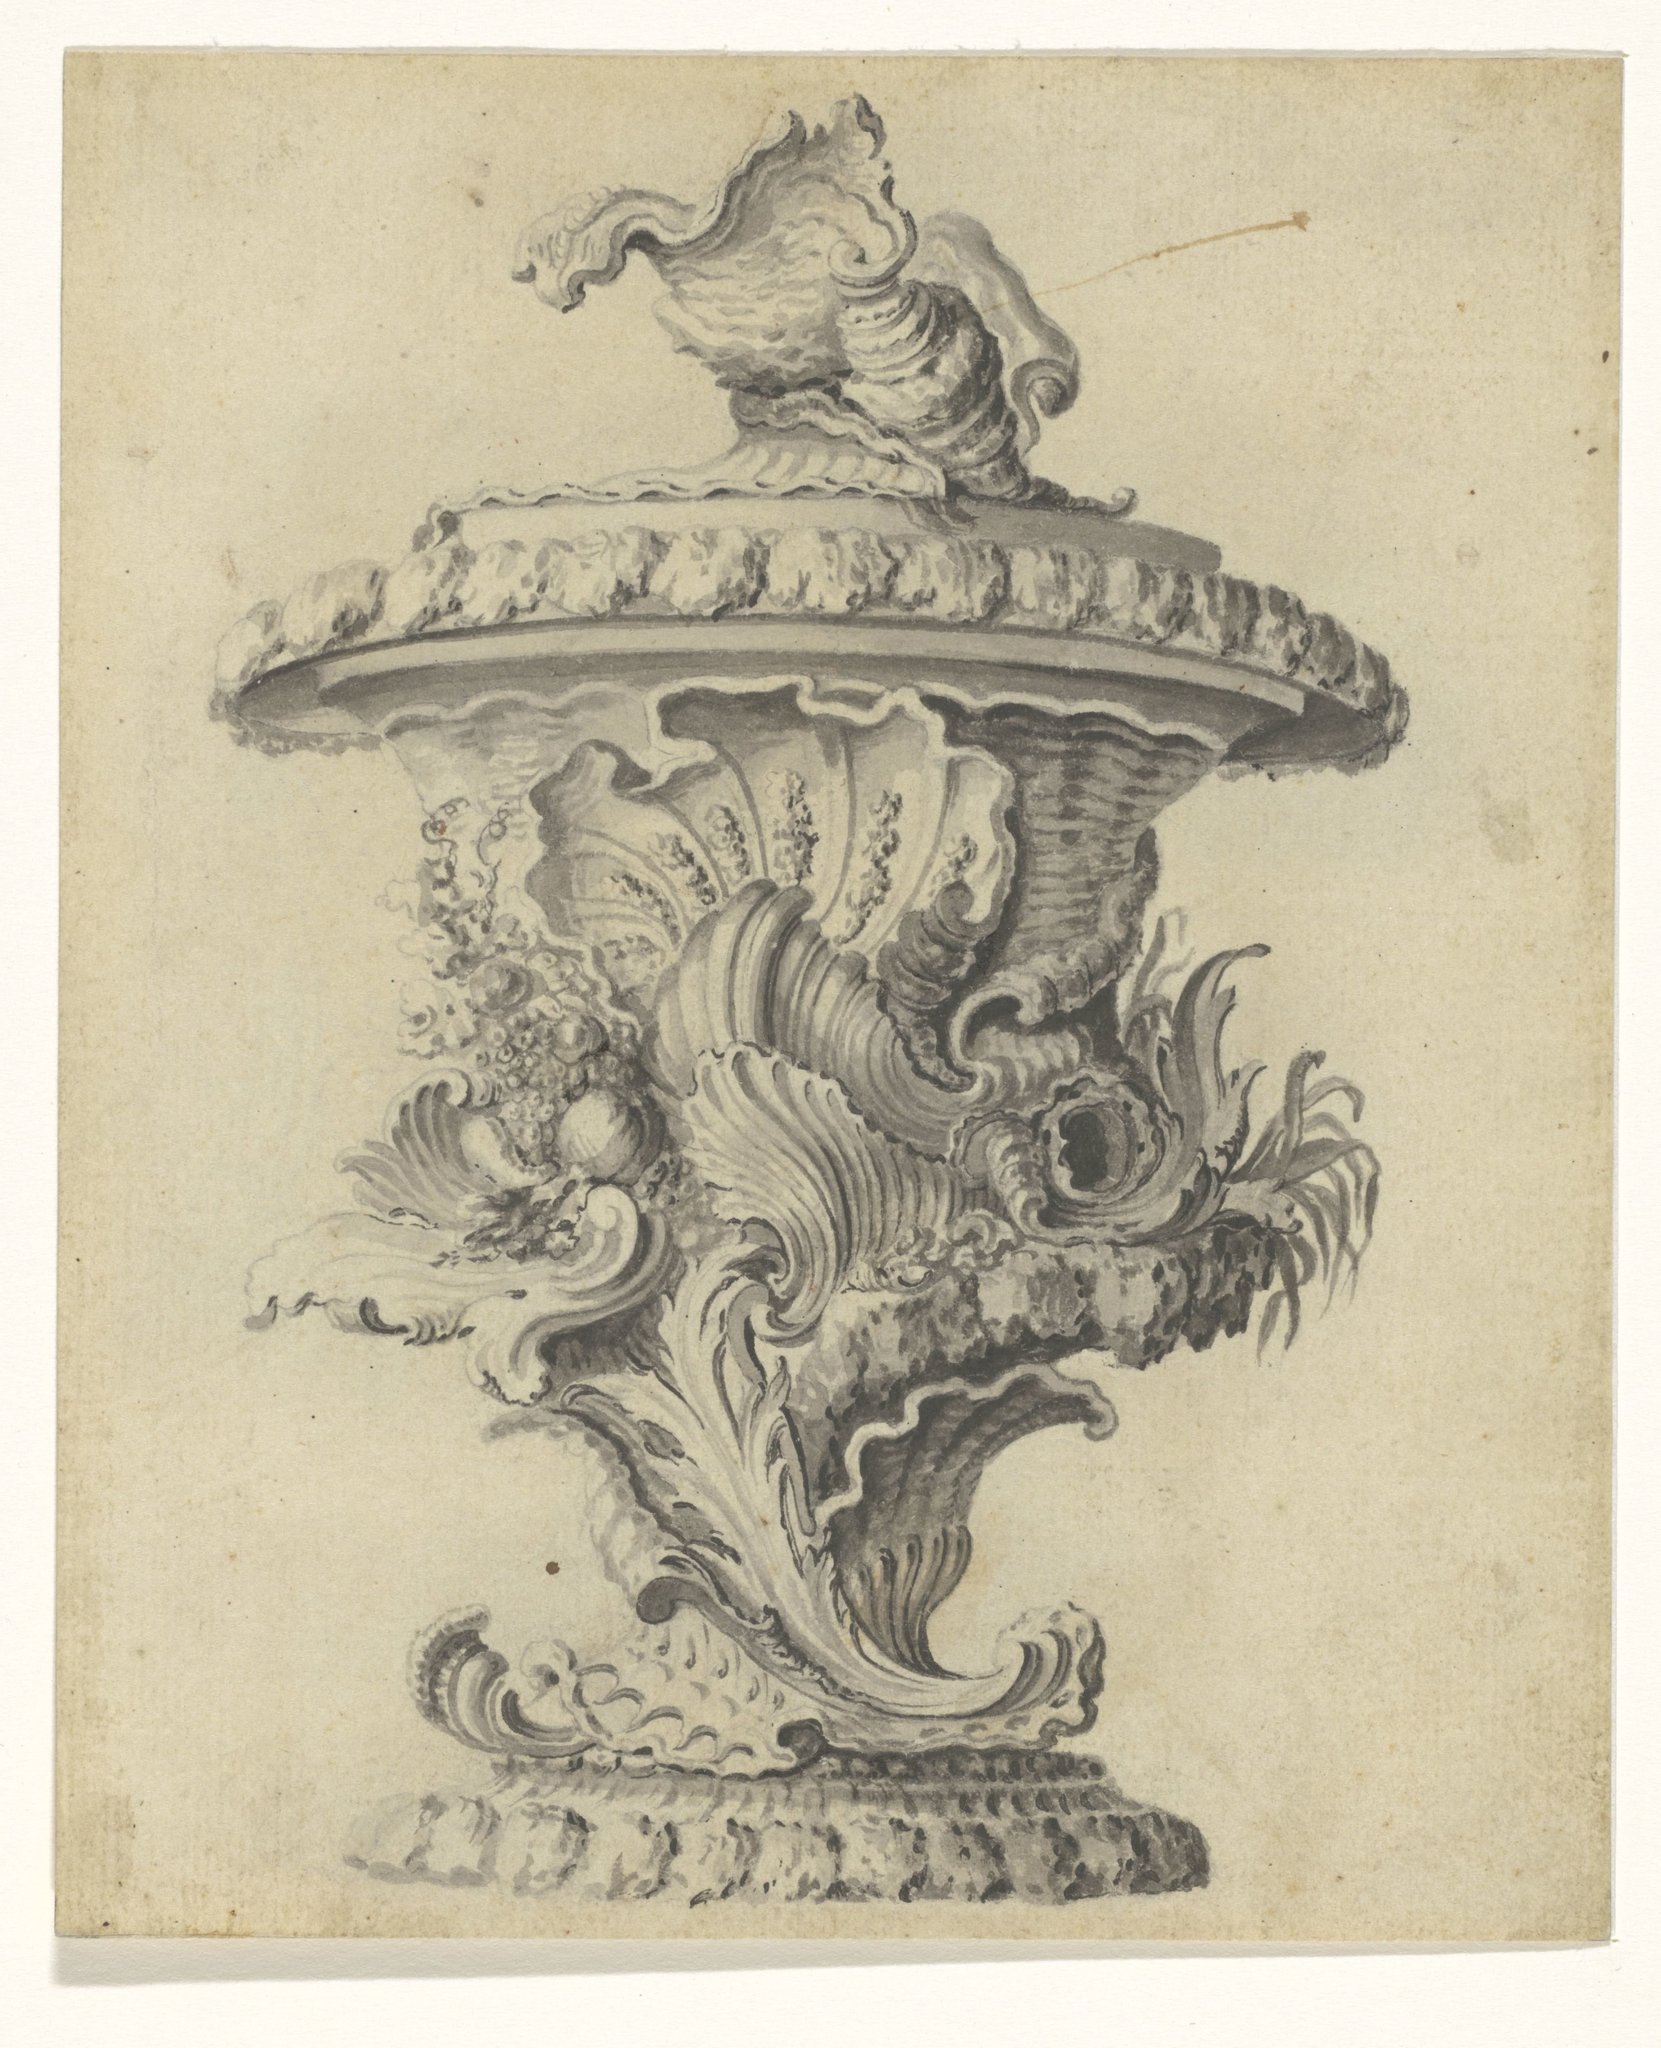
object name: design drawing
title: Vaas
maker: Anonymous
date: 1743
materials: ink, paper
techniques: brush, pen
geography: augsburg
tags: containers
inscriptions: watermark:, collector's mark: Lugt 1493a